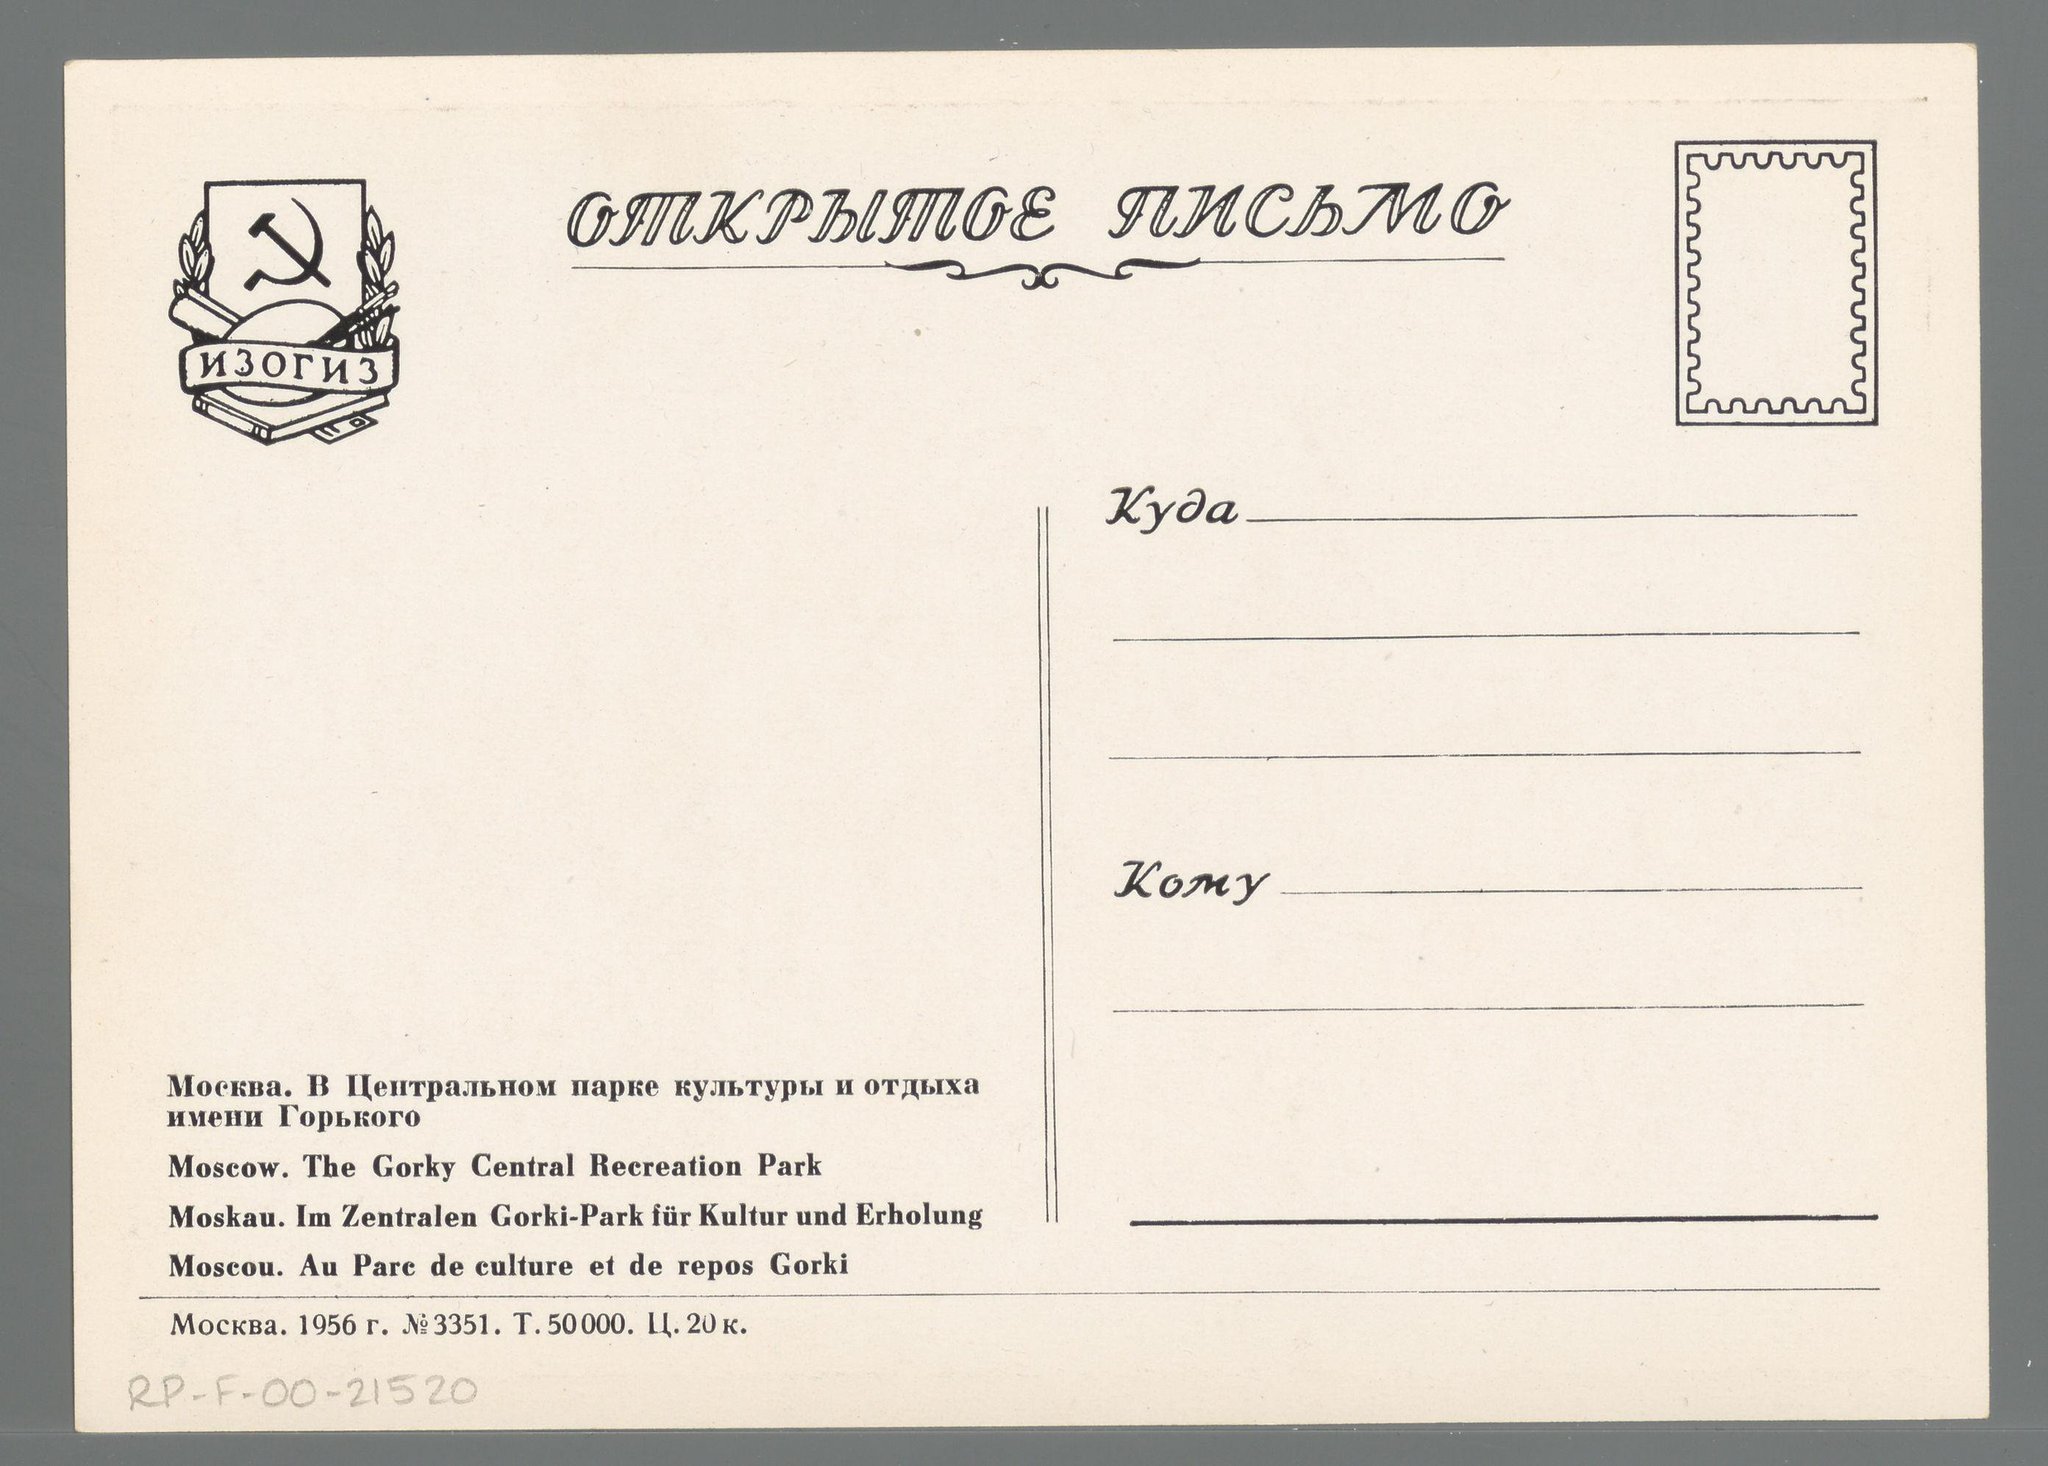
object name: ansichtkaart, prentbriefkaart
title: Moscow. The U.S.S.R. Agricultural Exhibition. Main Entrance / Moskau. Haupteingang der Landwirtschaftlichen Unionsausstellung / Moscou. Exposition agricole de l'U.R.S.S. Entrée principale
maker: Anonymous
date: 1956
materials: cardboard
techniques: color autotype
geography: moscow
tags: gate, entrance, temporary exhibition, 'salon'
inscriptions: date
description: De titel op object staat ook in het Russisch.